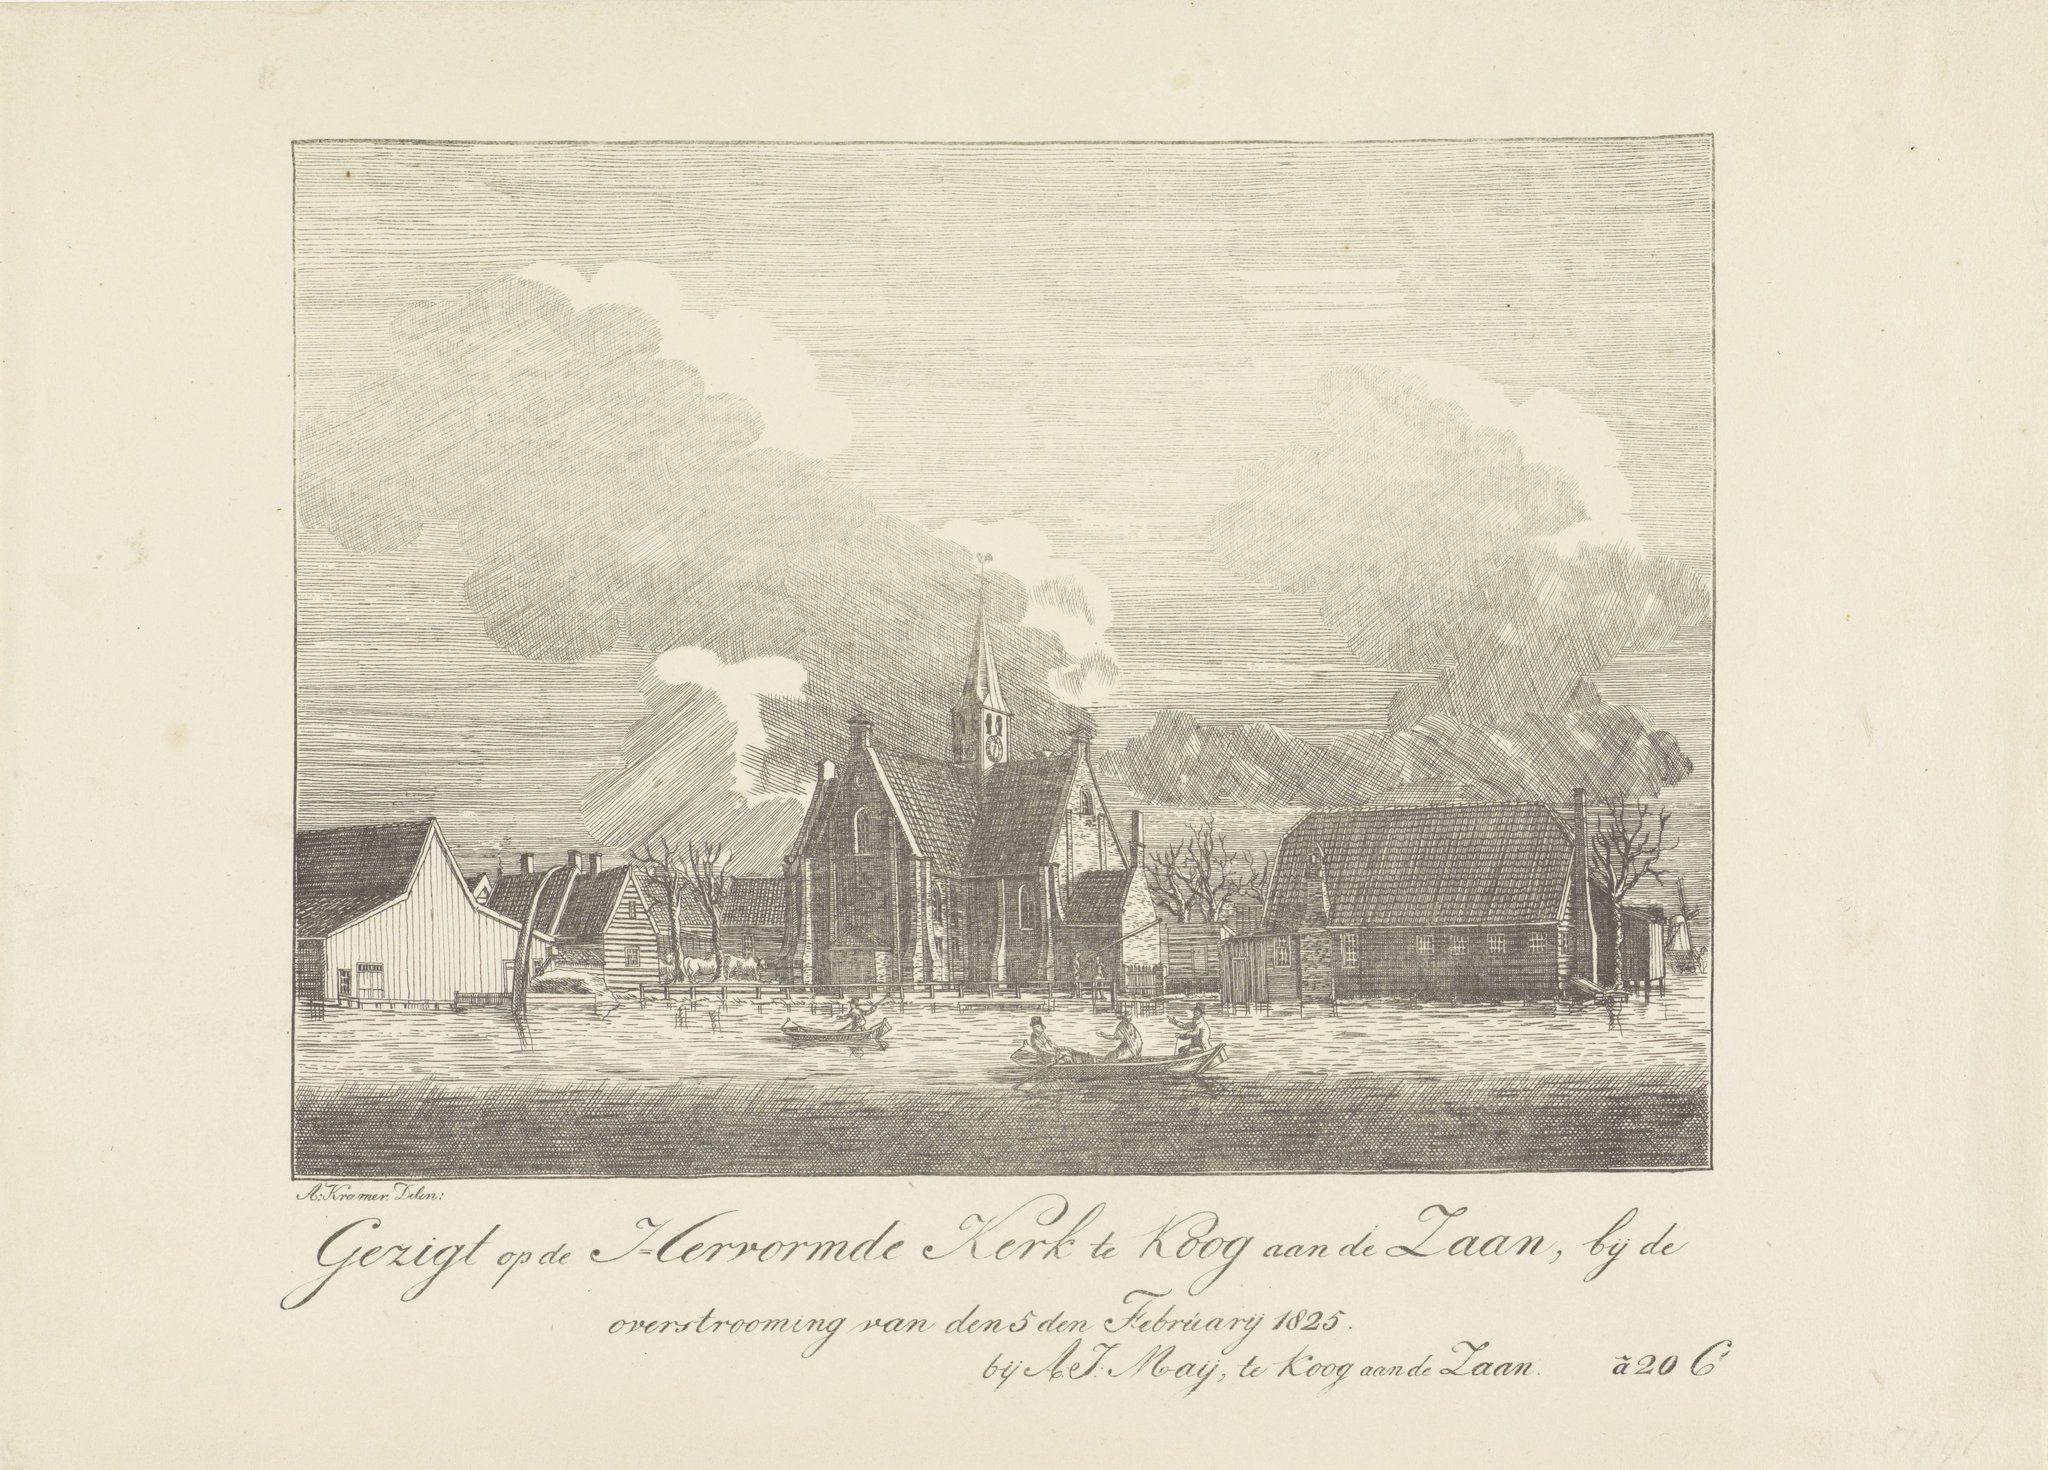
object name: print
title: Gezigt op de Hervormde Kerk te Koog aan de Zaan, bij de overstrooming van den 5den Februarij 1825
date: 1825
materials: paper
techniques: lithograph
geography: koog aan de zaan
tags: flood, koog aan de zaan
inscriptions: collector's mark: Lugt 2228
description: Gezicht op het onder water staande dorp van Koog aan de Zaan tijdens de watersnood op 5 februari 1825. Centraal de Hervormde kerk, op de voorgrond drie personen in een roeibootje. Achter het adres van de uitgever is de prijs 'à 20 Ct' vermeld. Zie ook de pendant.